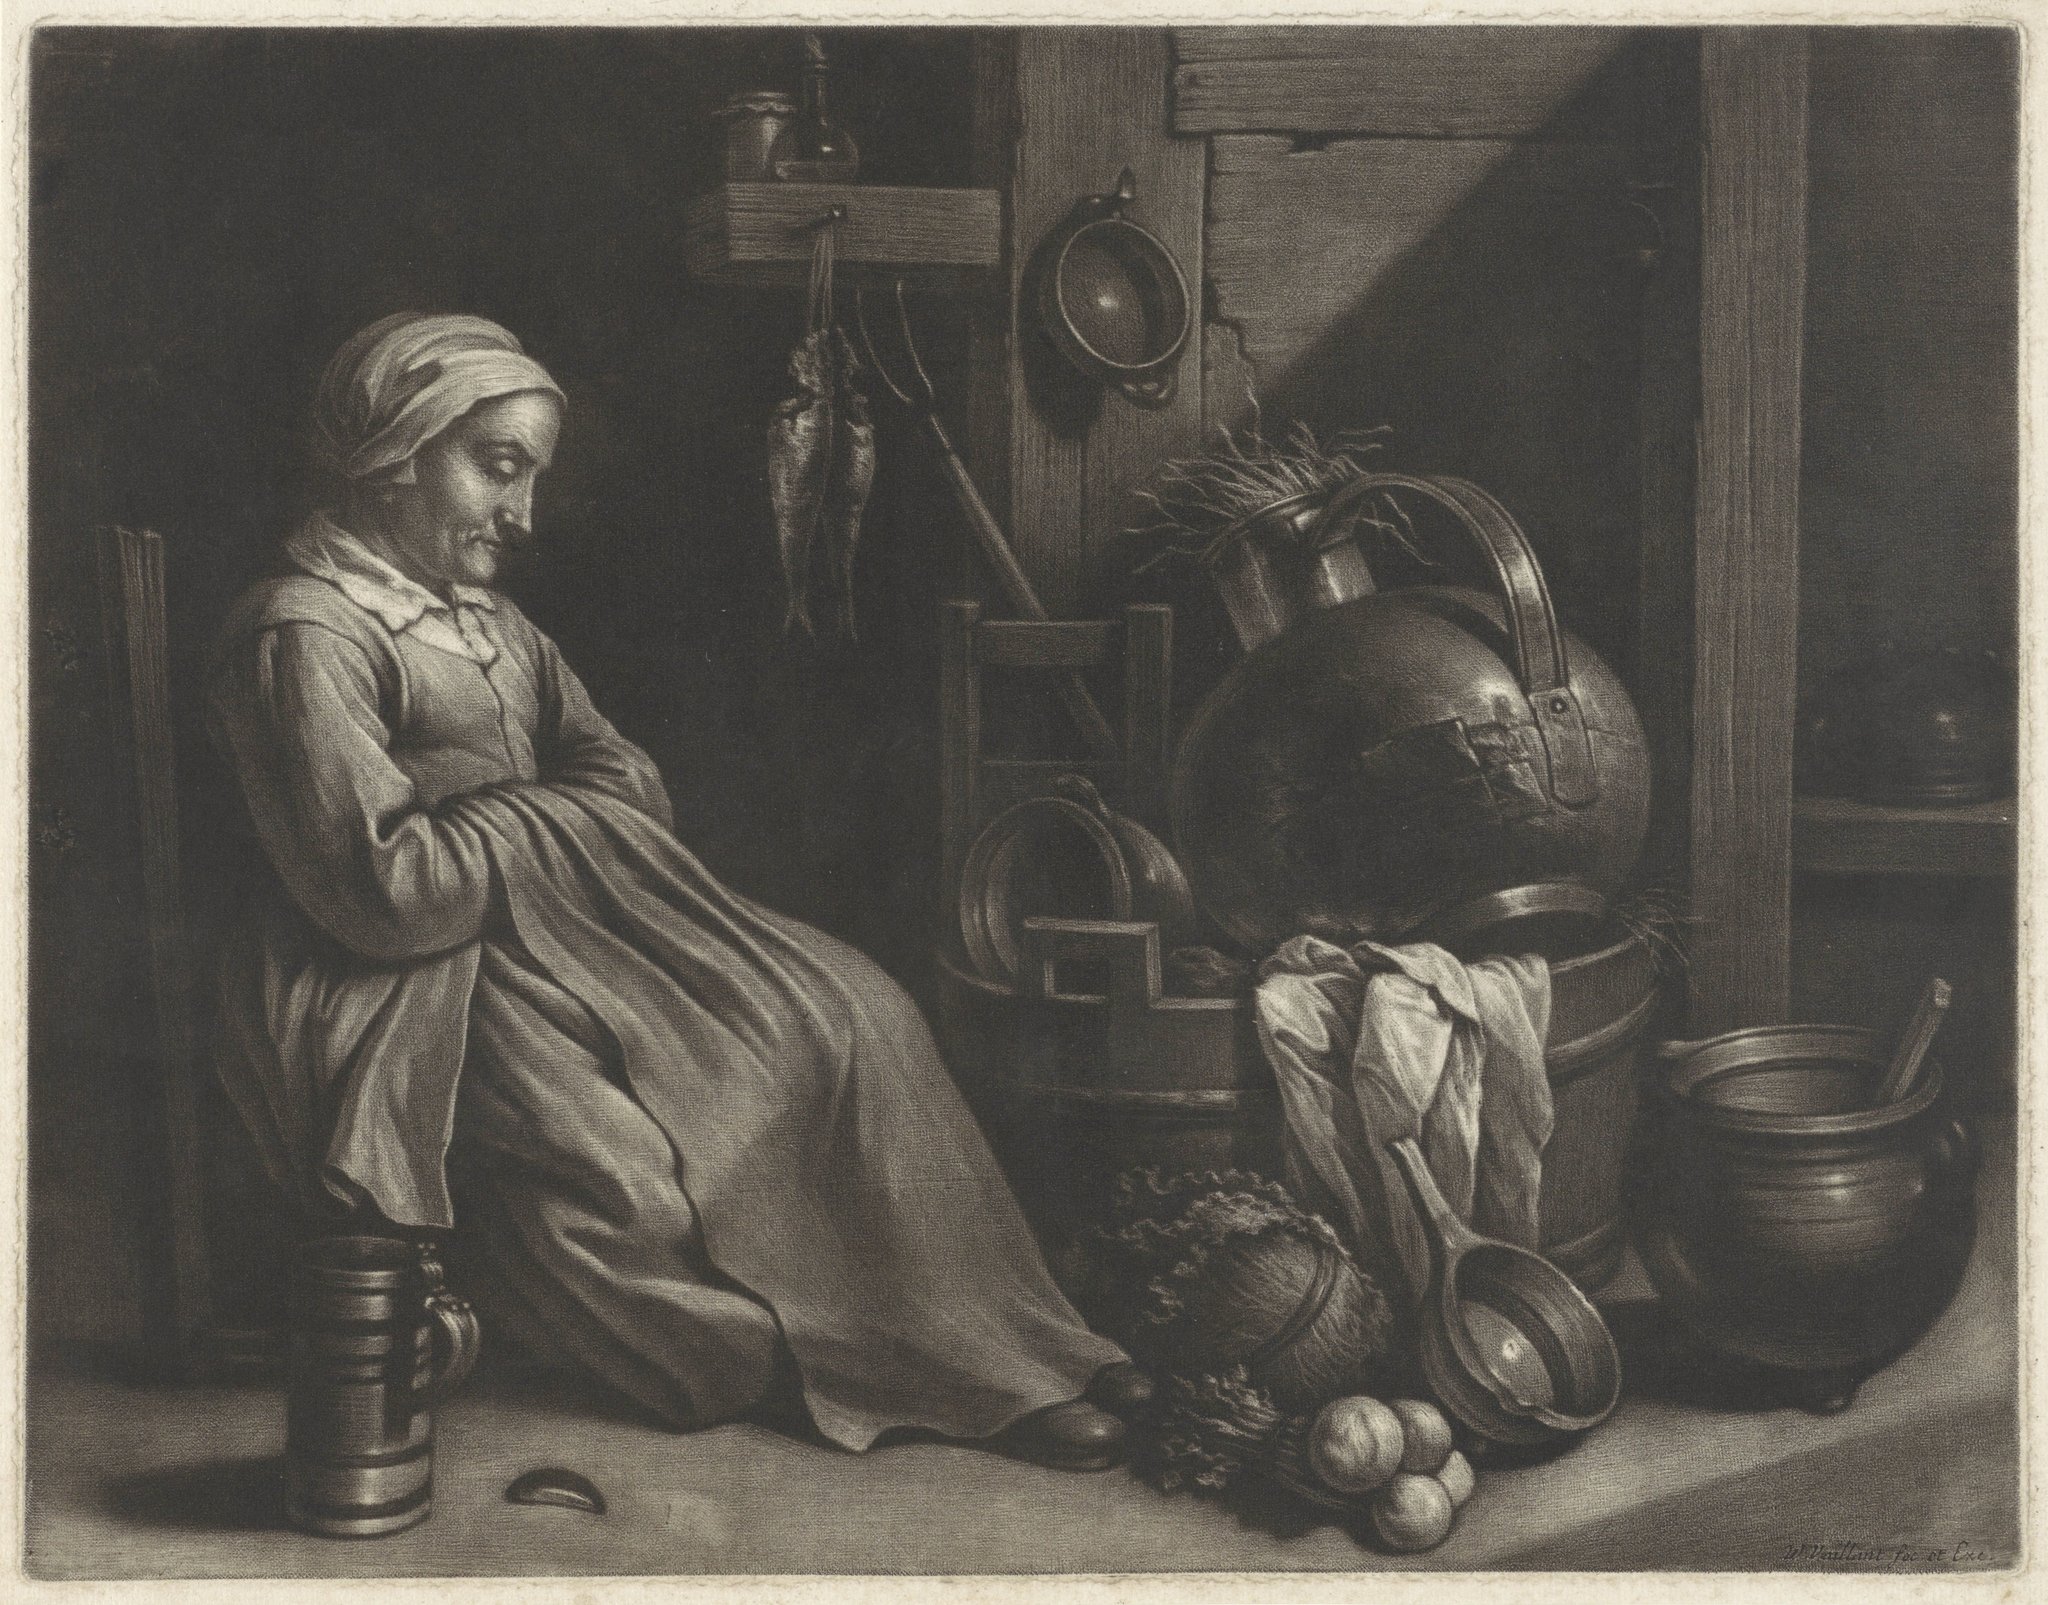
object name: print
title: Slapende dienstmeid in een keuken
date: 1658-1677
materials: paper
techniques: mezzotint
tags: sleeping in chair, old woman, kitchen-interior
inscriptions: collector's mark: Lugt 2228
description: In een keuken zit een oude dienstmeid te slapen op een stoel. Op de grond naast haar staat een pul en voor haar liggen groenten en keukenspullen.